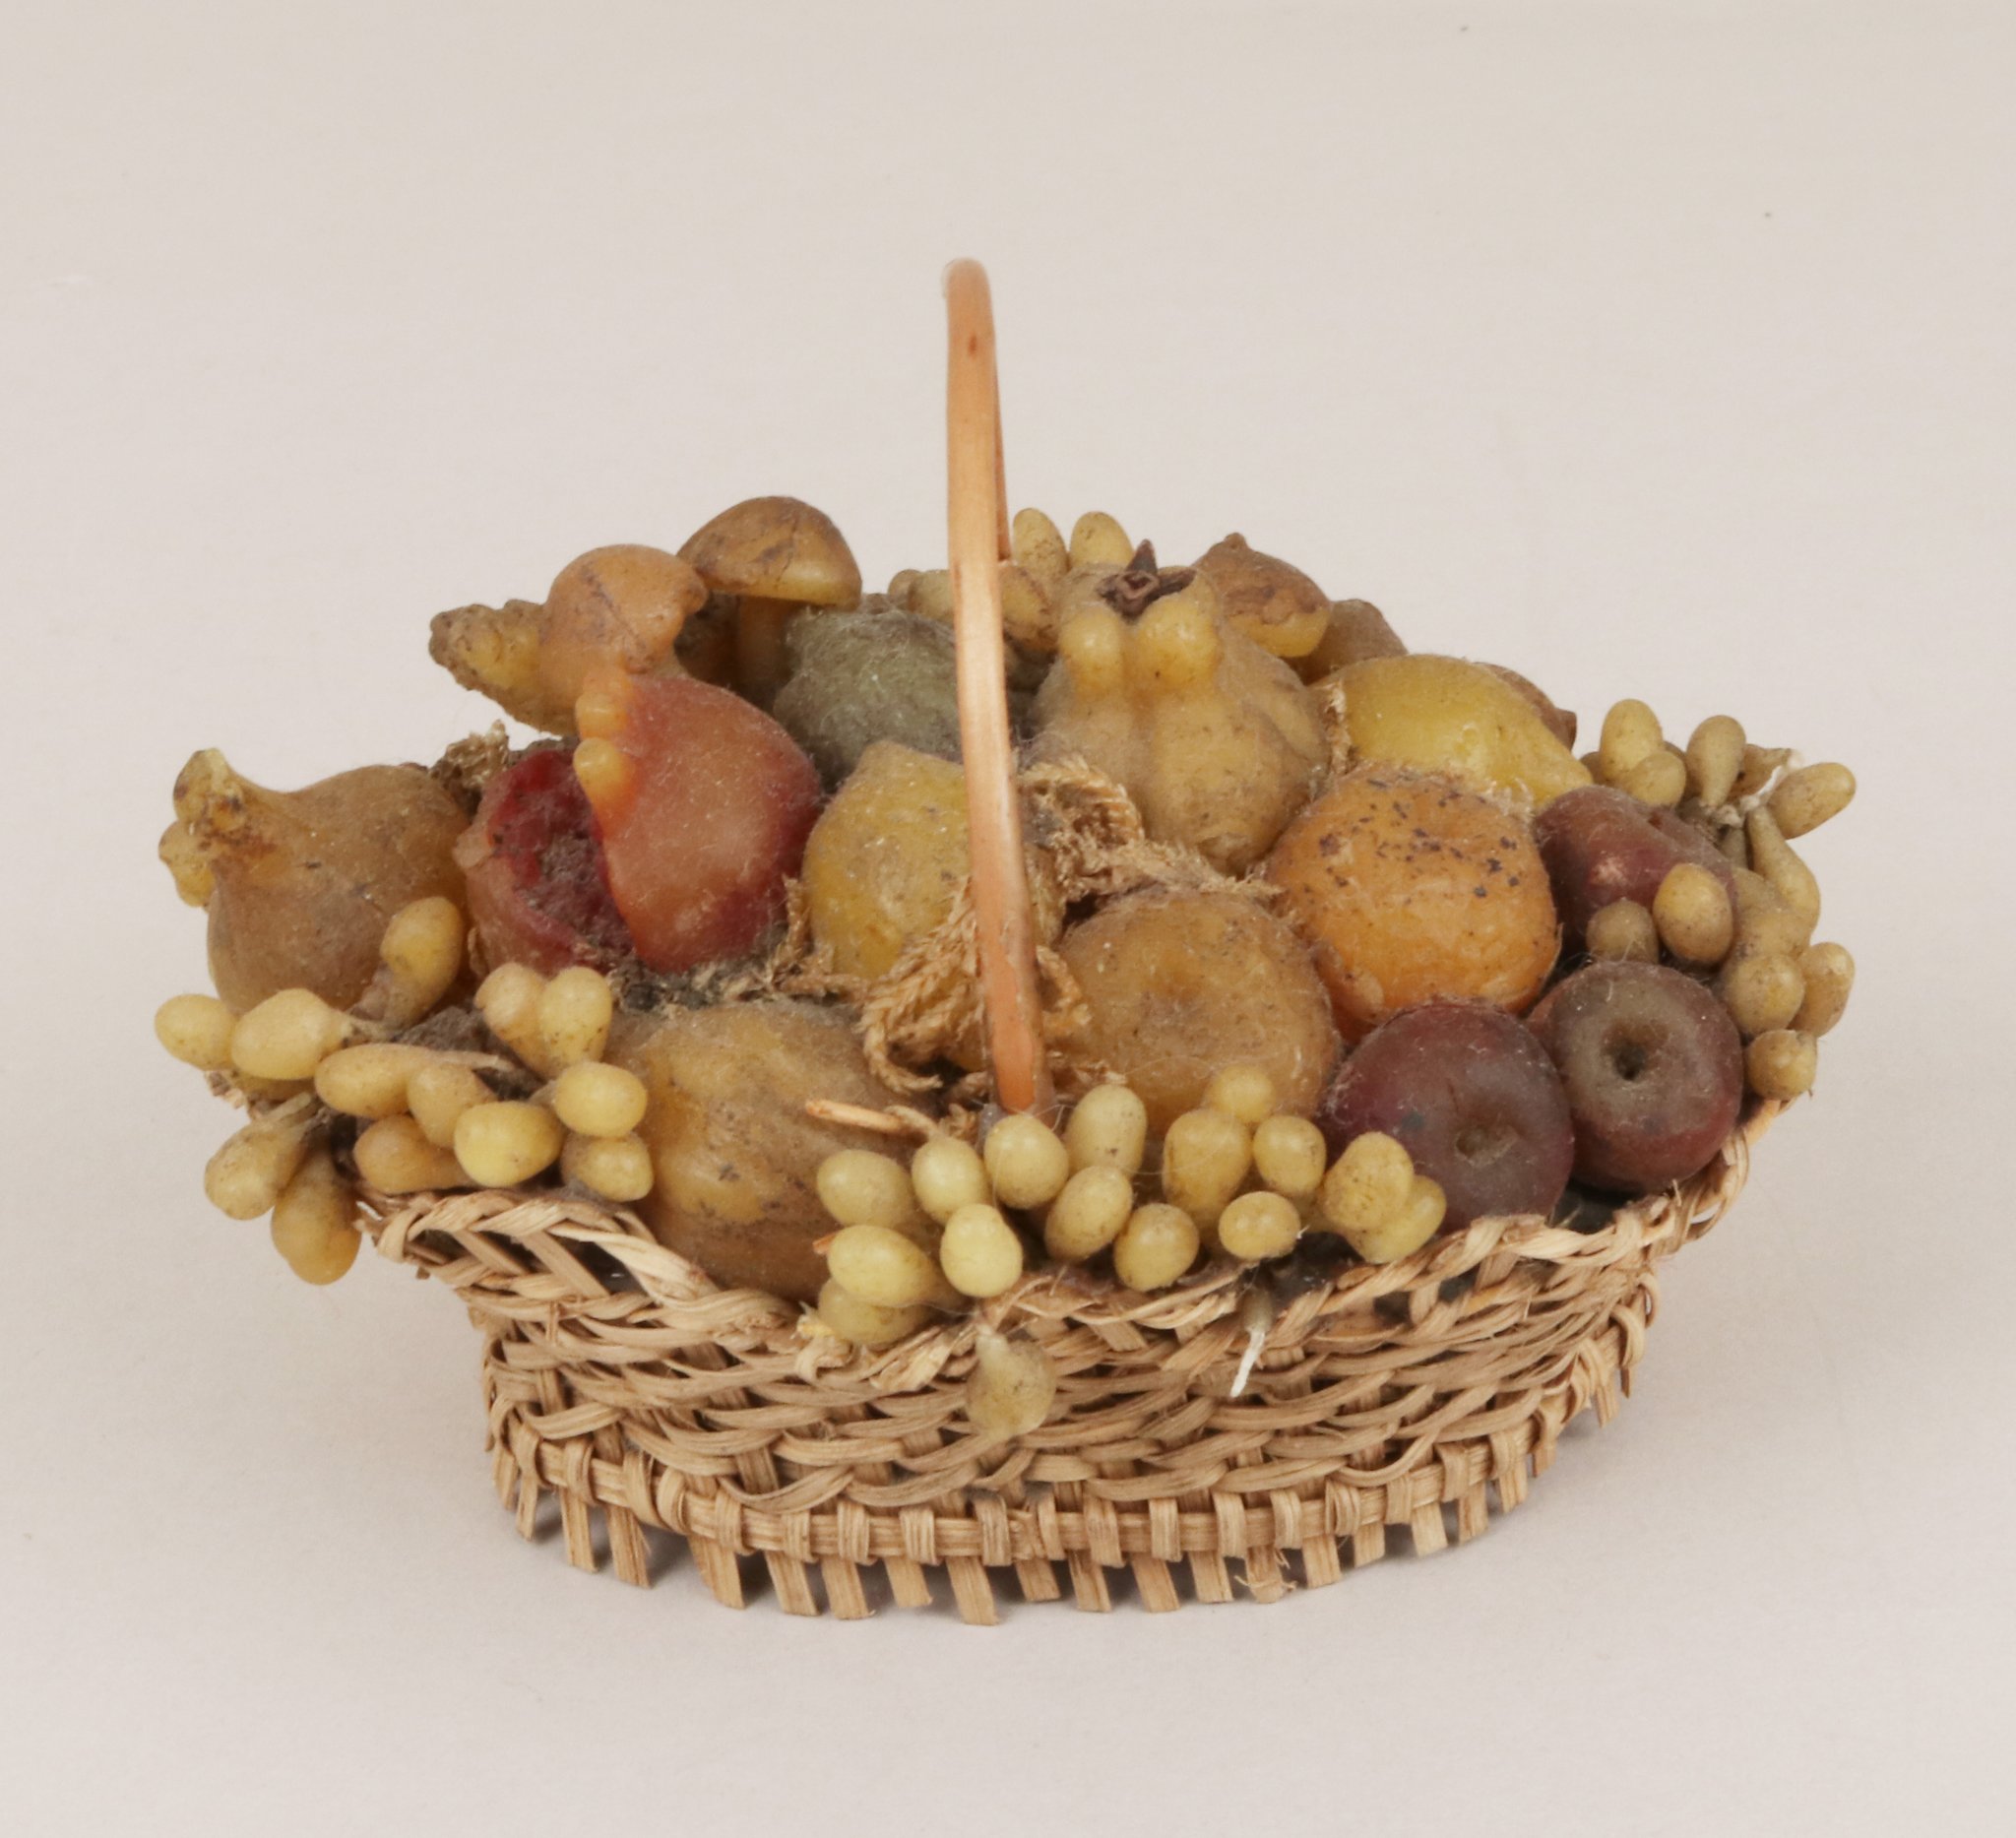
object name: crèche accessory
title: Large basket of fruit with handle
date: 1701-1800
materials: wax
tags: fruit,grapes